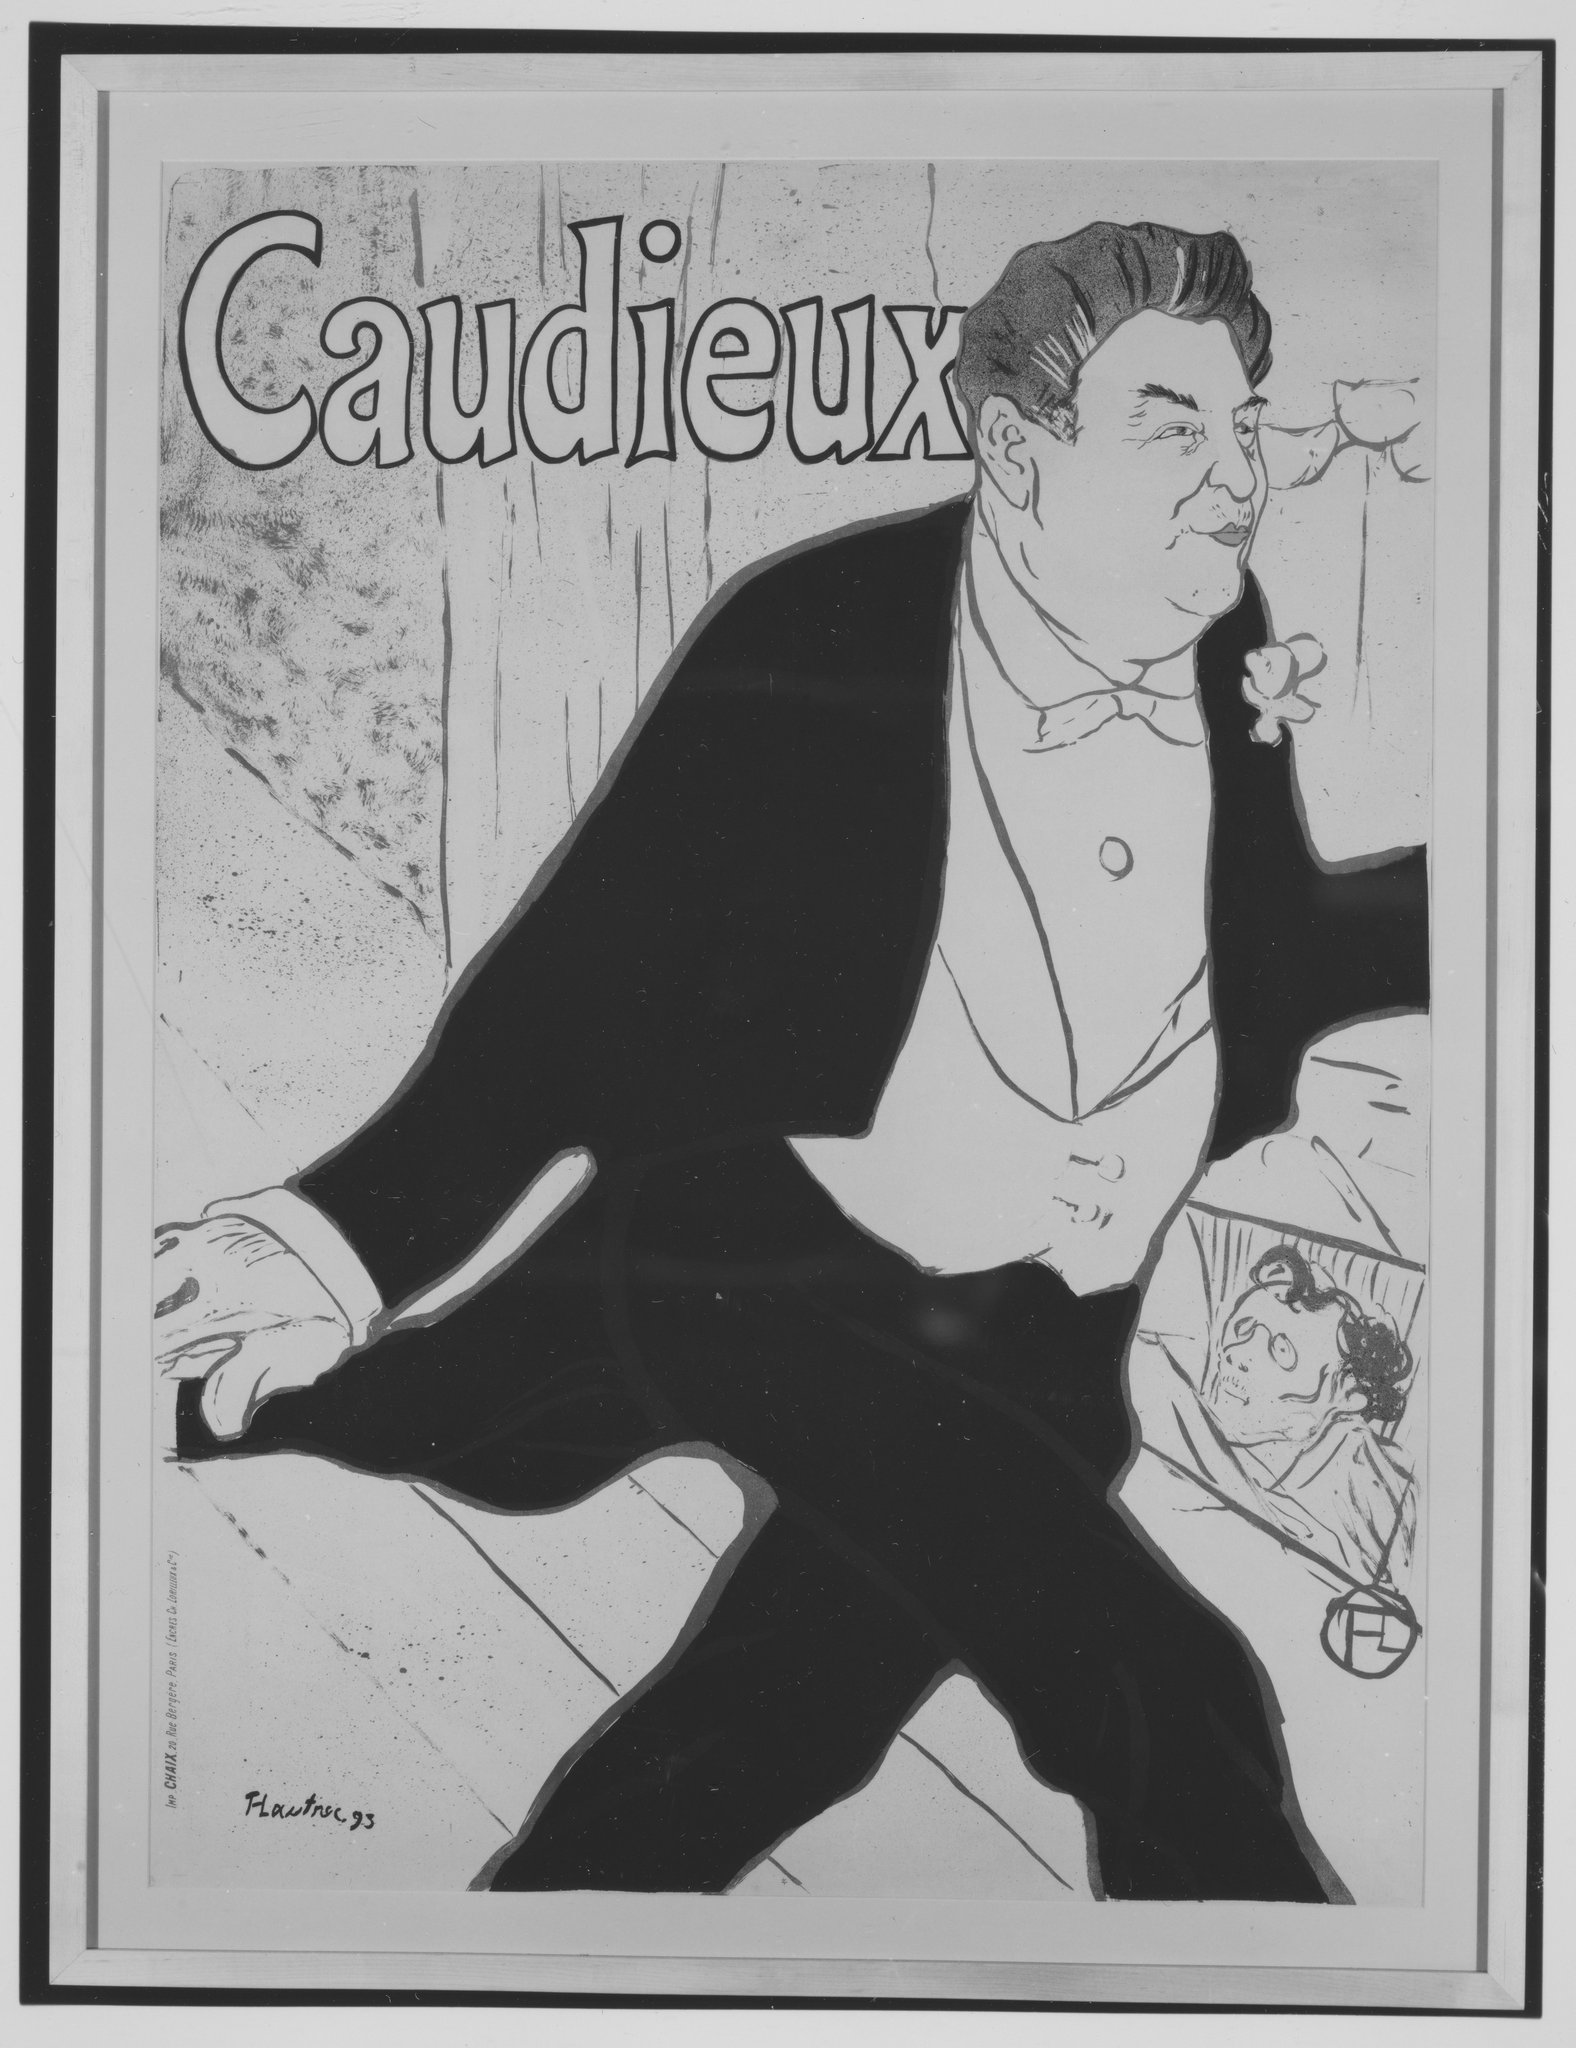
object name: print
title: Caudieux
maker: henri de toulouse-lautrec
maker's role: artist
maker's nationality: french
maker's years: 1864-1901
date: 1893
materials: paper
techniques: lithograph, printing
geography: france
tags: heads,men